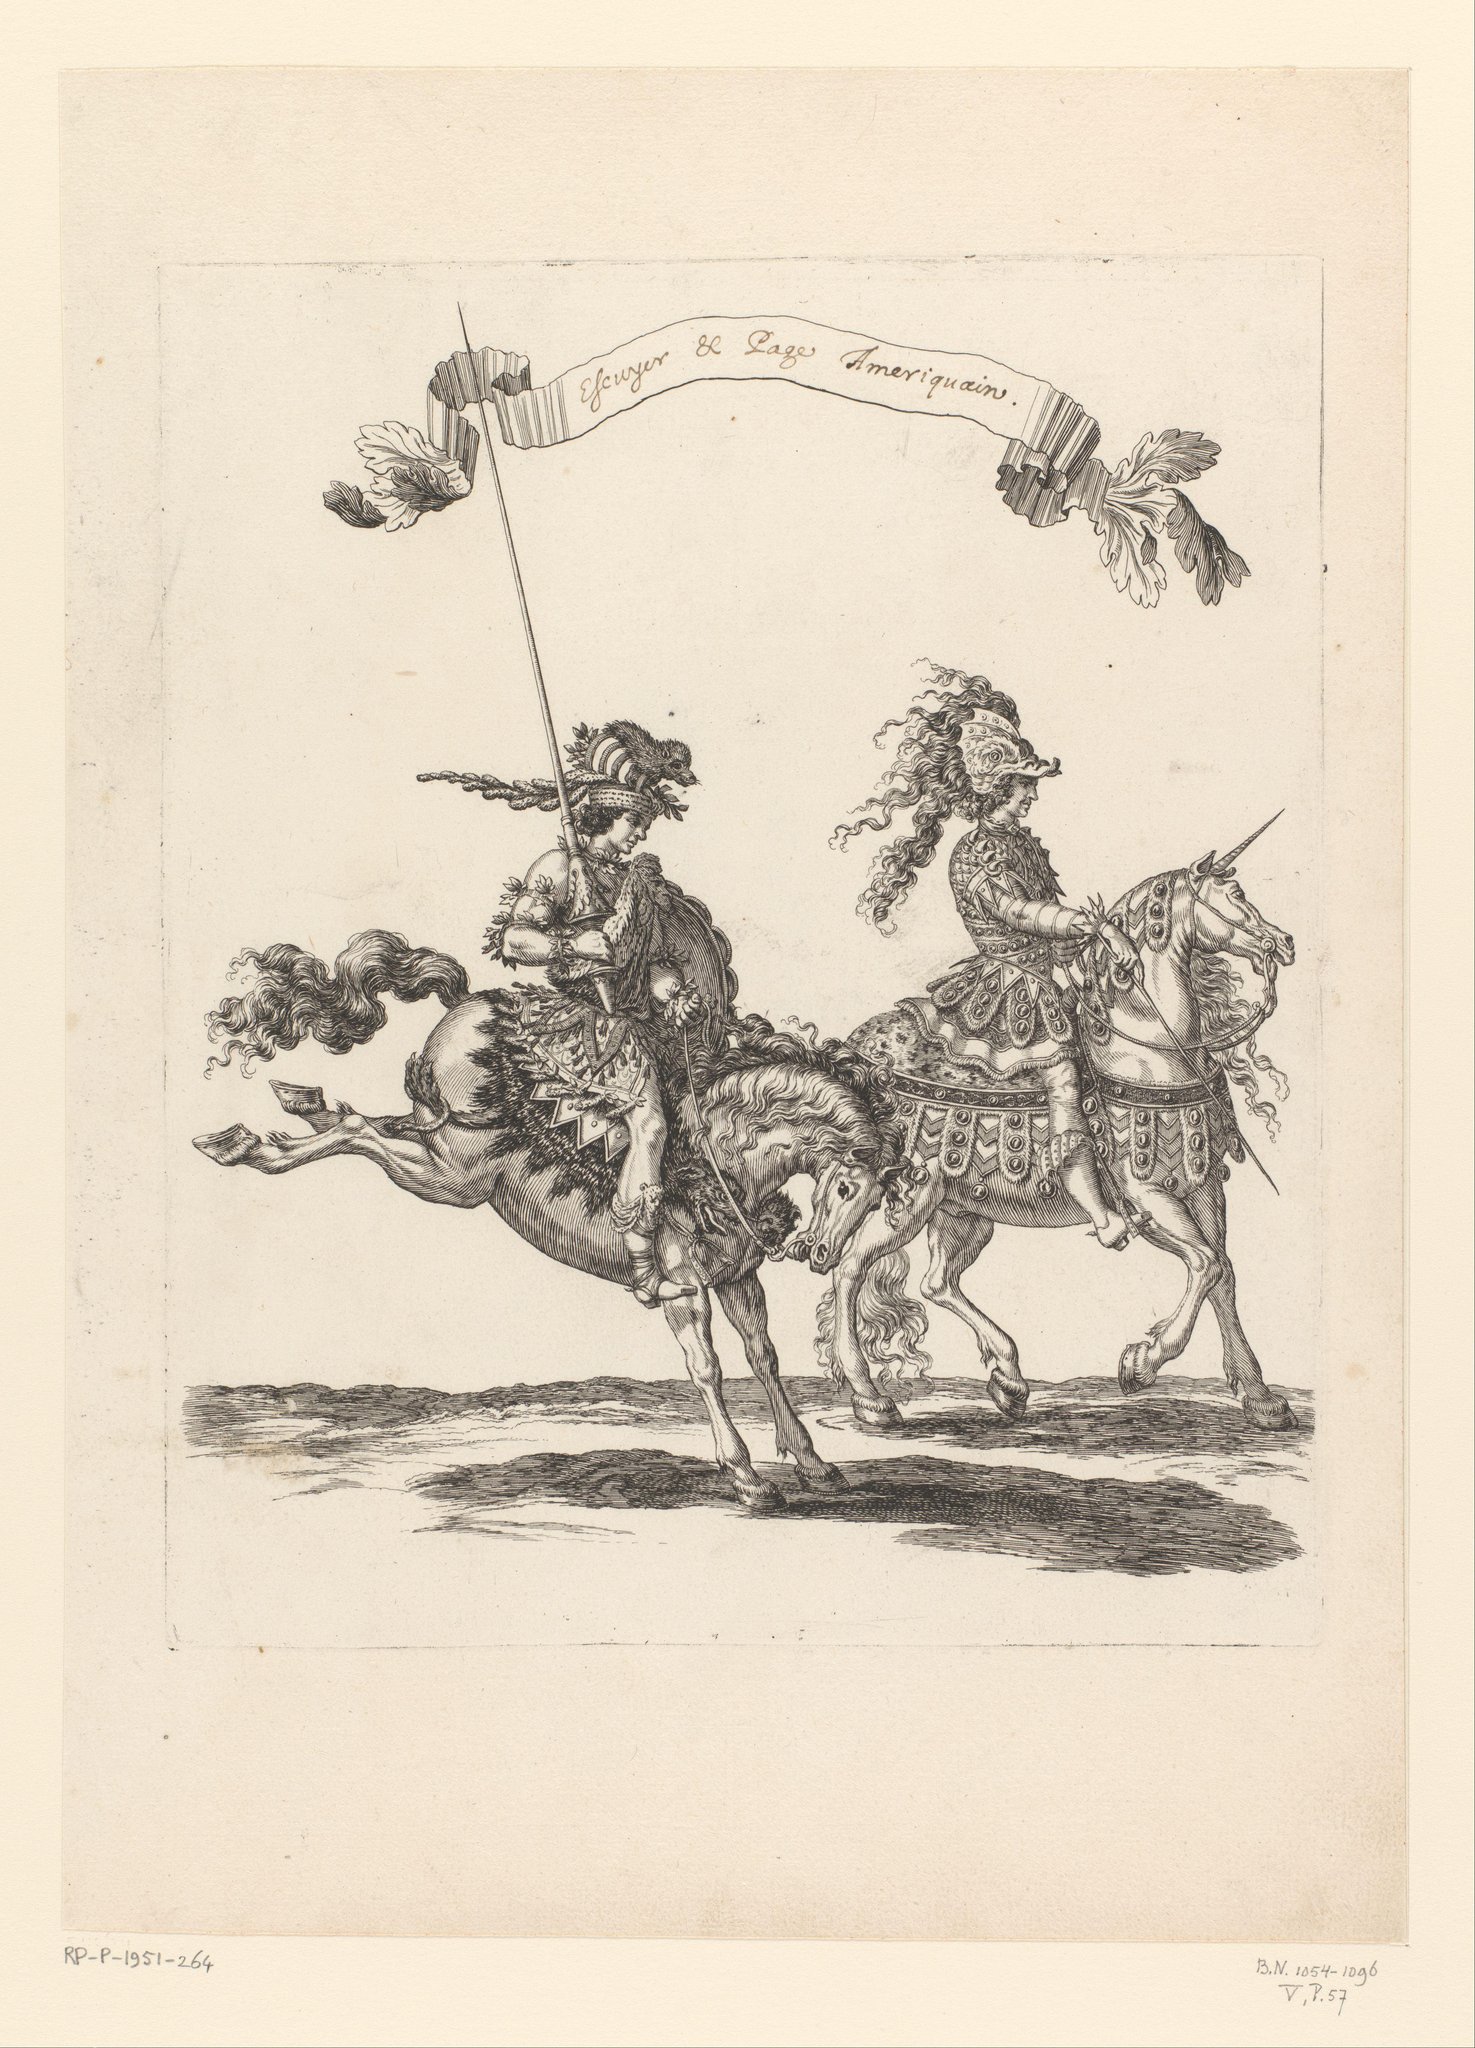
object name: book illustration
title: Escuyer & Pages Amériquains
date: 1670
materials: paper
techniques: etching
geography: paris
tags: unicorn, tournament, joust, tilt, horse, festivities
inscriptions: collector's mark: Lugt 2228, inscription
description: Prent uit: Perrault, Charles. Courses de testes et de bague faites par le Roy et par les princes et seigneurs de sa cour en l'année M.DC.LXII. Parijs: Imprimerie Royale, 1670. De prenten illustreren de door Lodewijk XIV georganiseerde festiviteiten in juni 1662 te Tuileries, zoals steekspelen met figuren in verschillende kostuums.